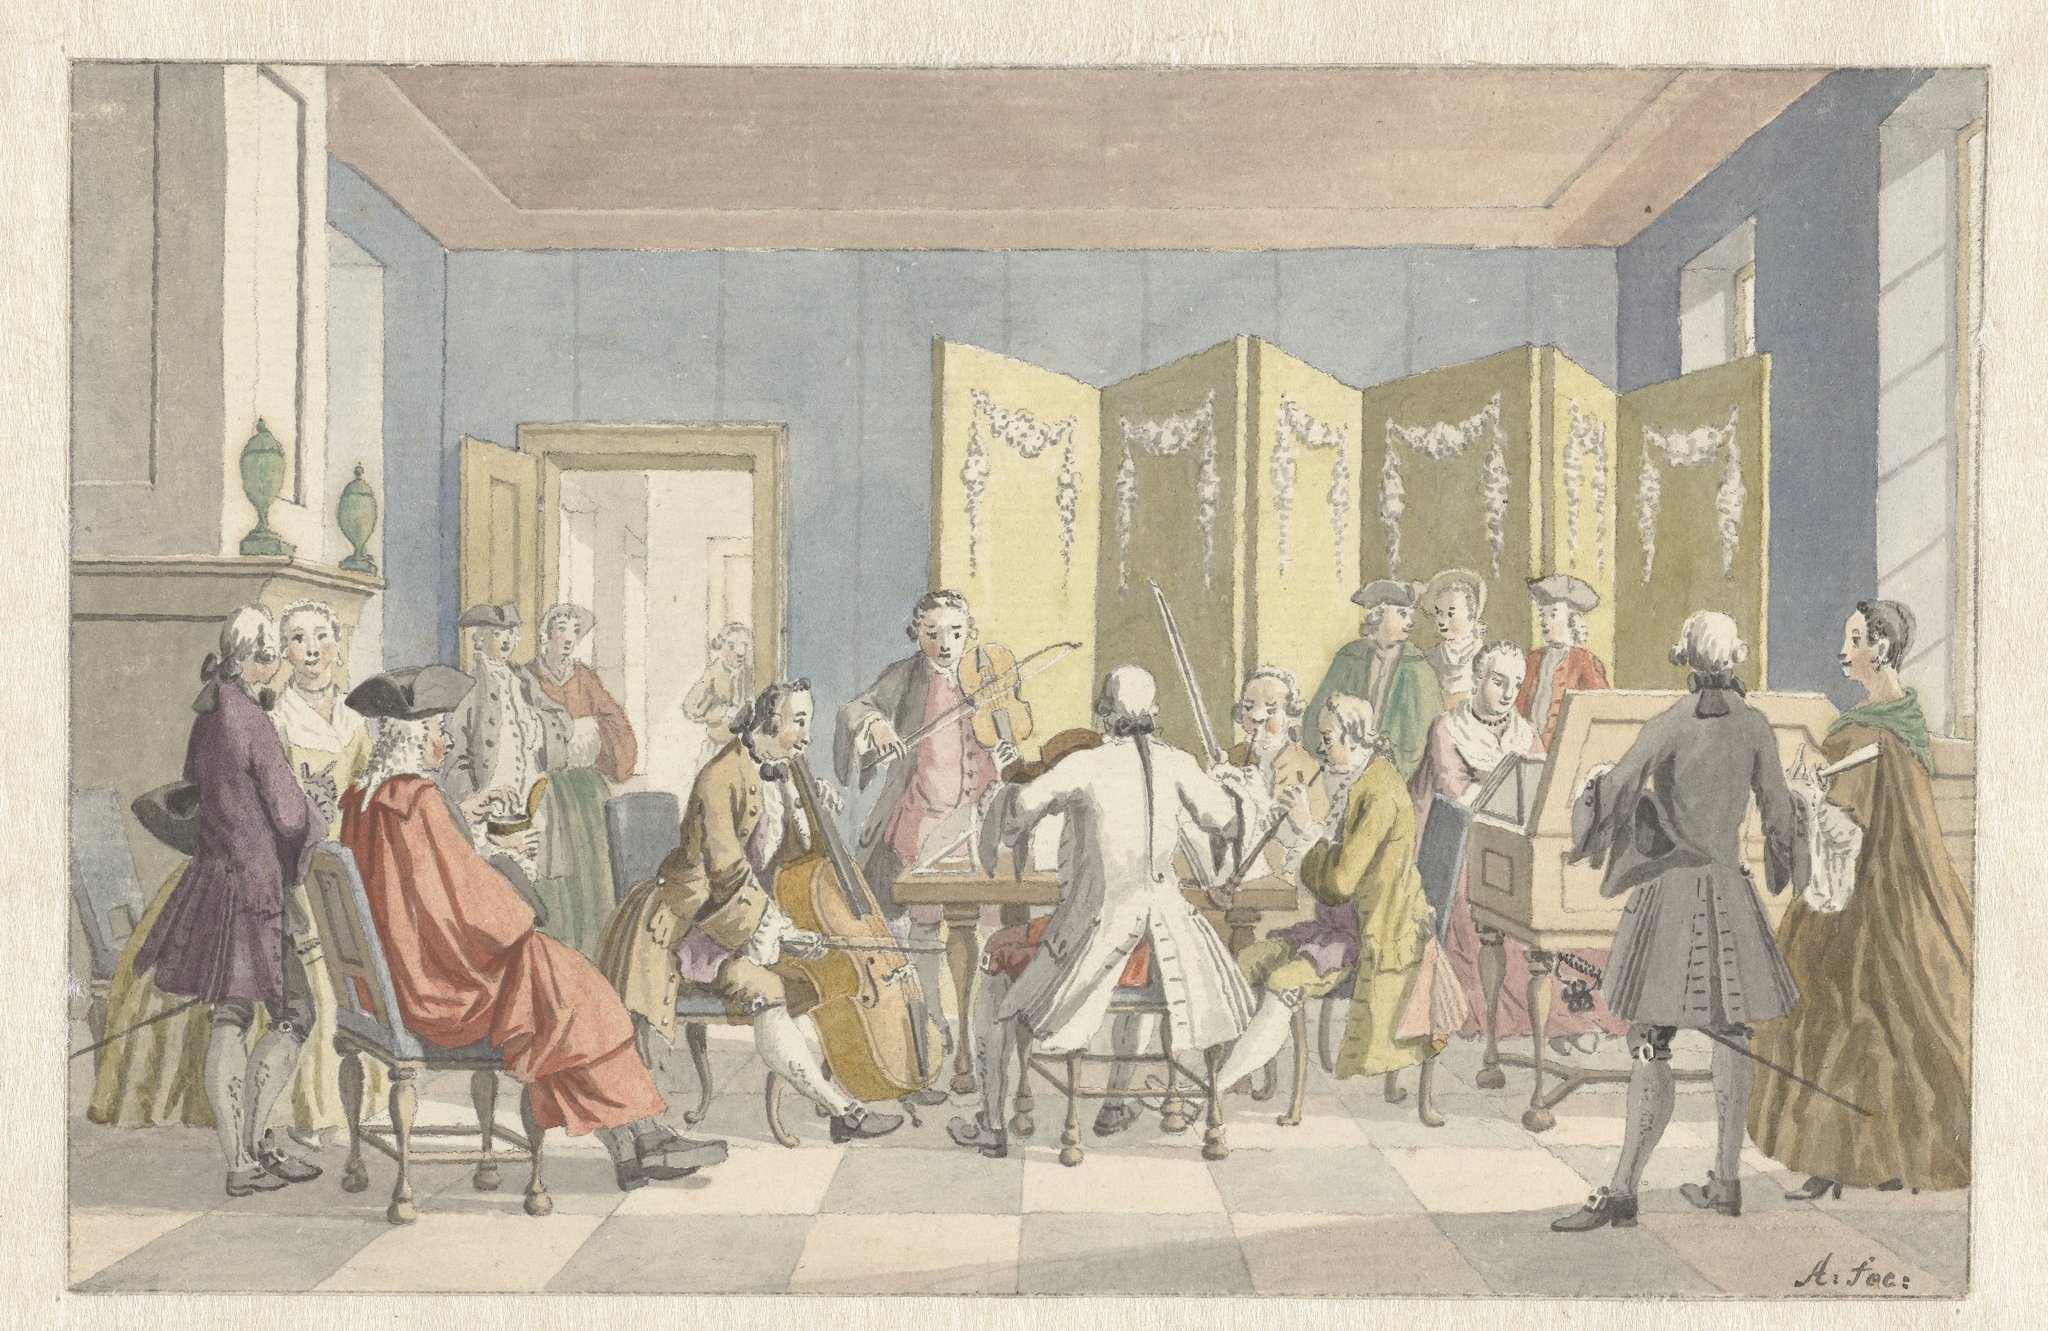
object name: drawing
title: Interieur met musicerend gezelschap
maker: nicolaes aartman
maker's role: draughtsman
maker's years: 1713-1760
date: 1723-1760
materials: paper, pencil, watercolor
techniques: brush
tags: small group of musicians, chamber orchestra, jazz band